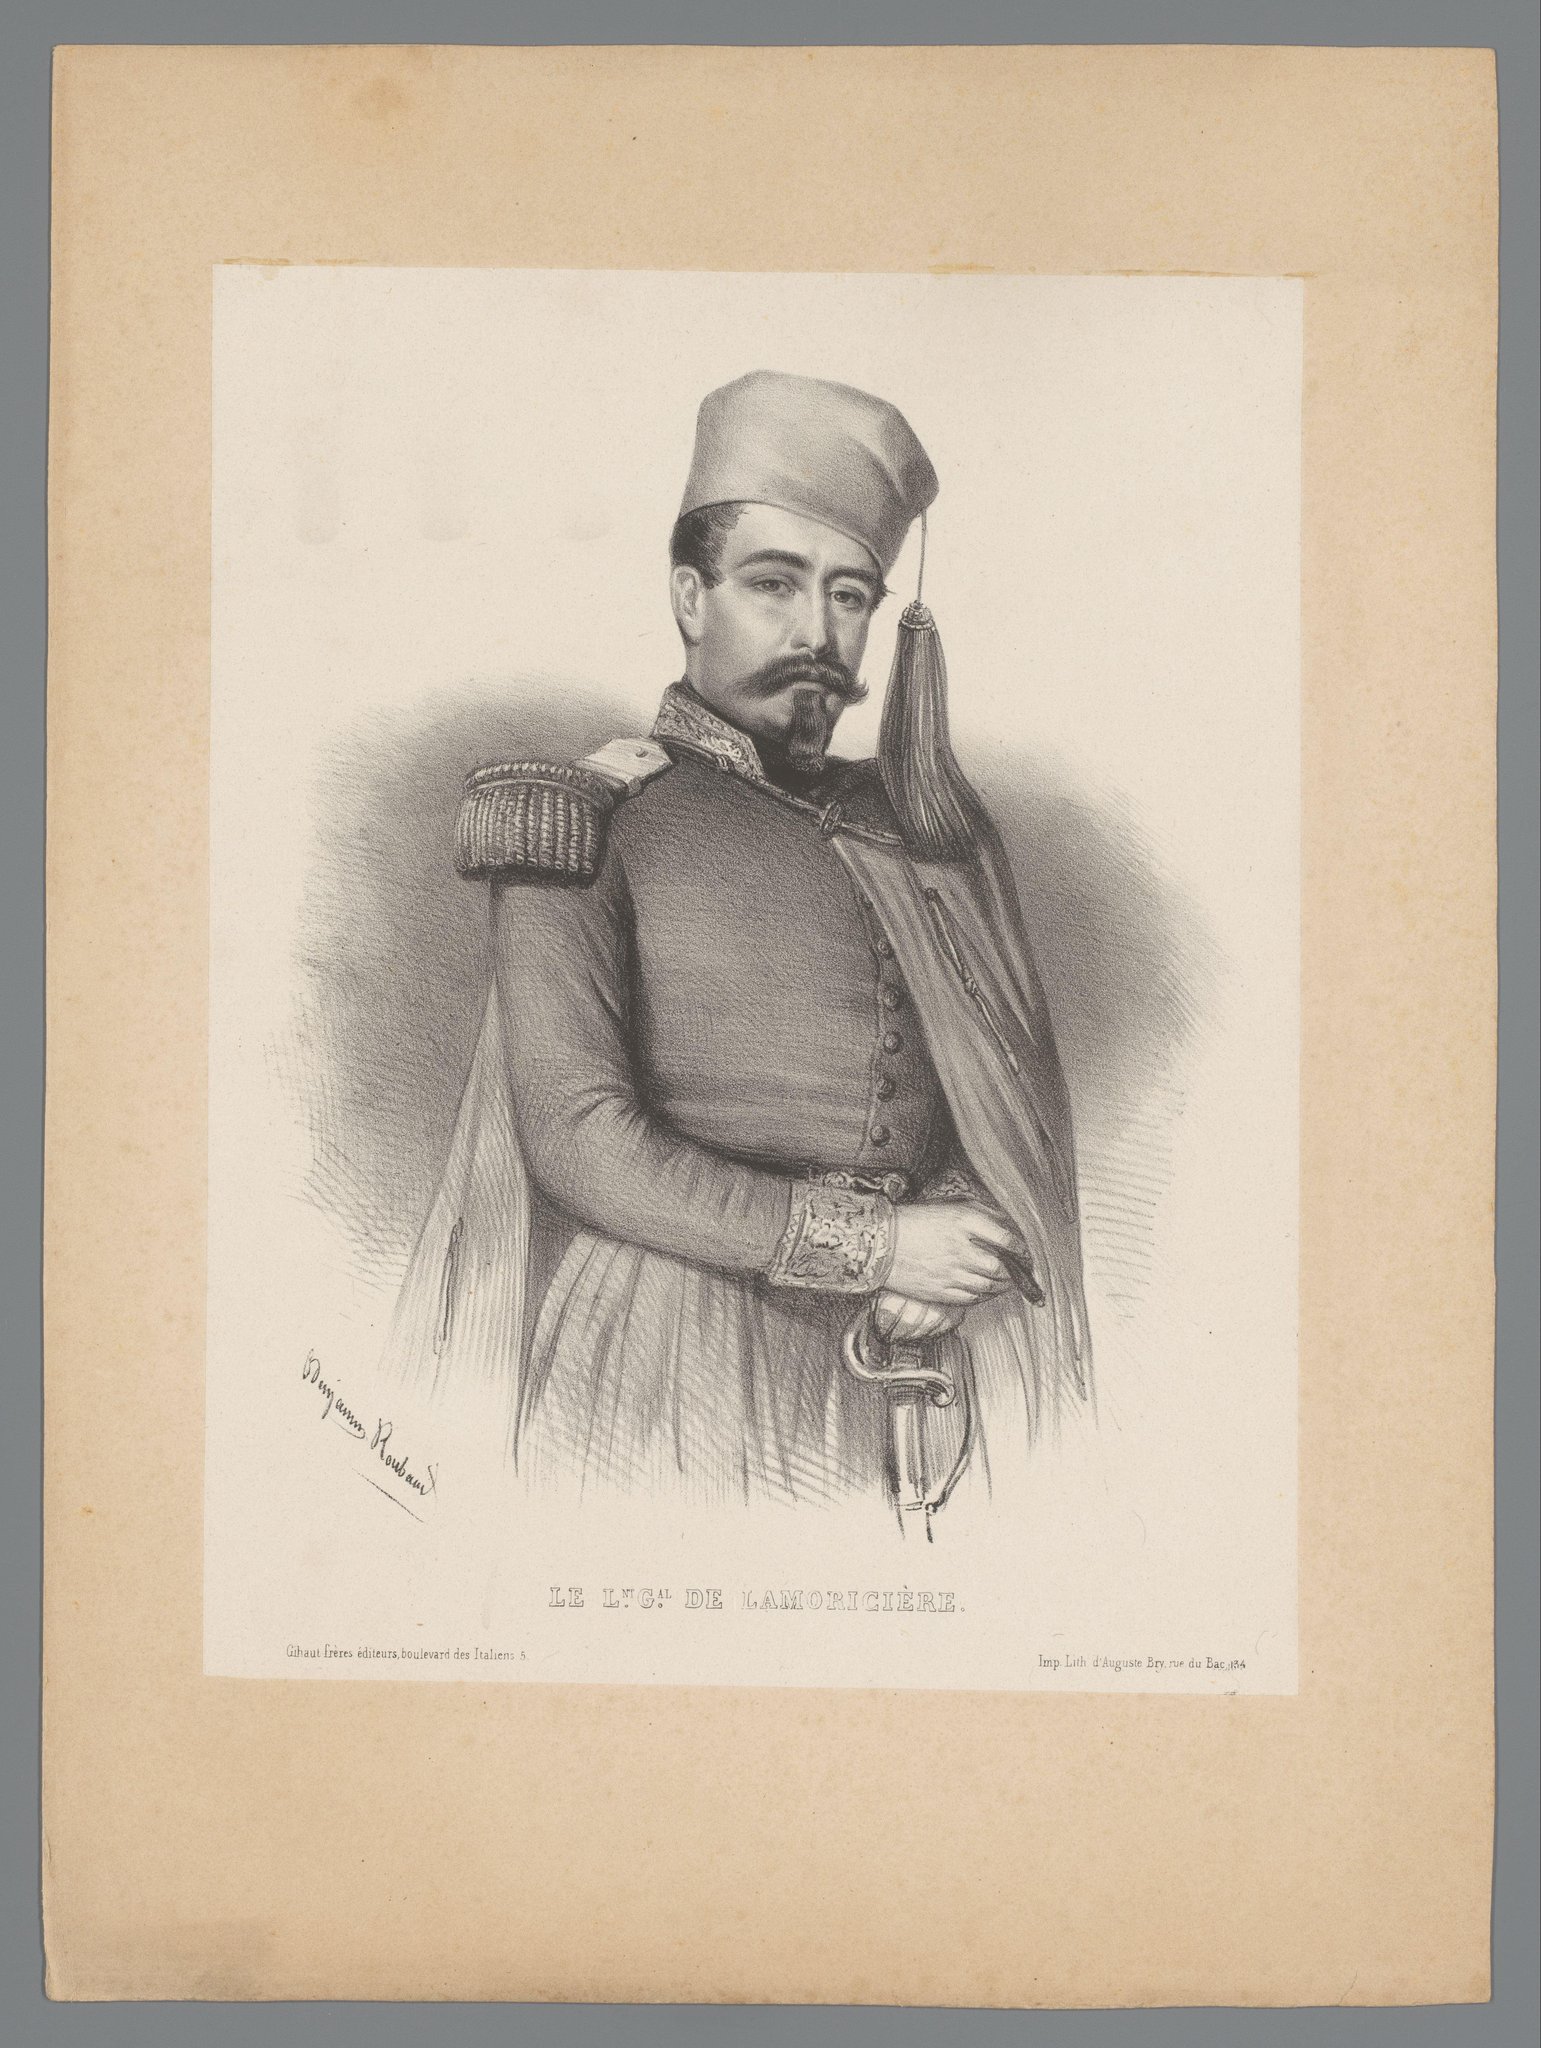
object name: print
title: Herinneringen aan Afrika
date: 1842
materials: paper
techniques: lithograph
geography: paris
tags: commander-in-chief, general, marshal, historical persons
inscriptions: collector's mark: Lugt 2228